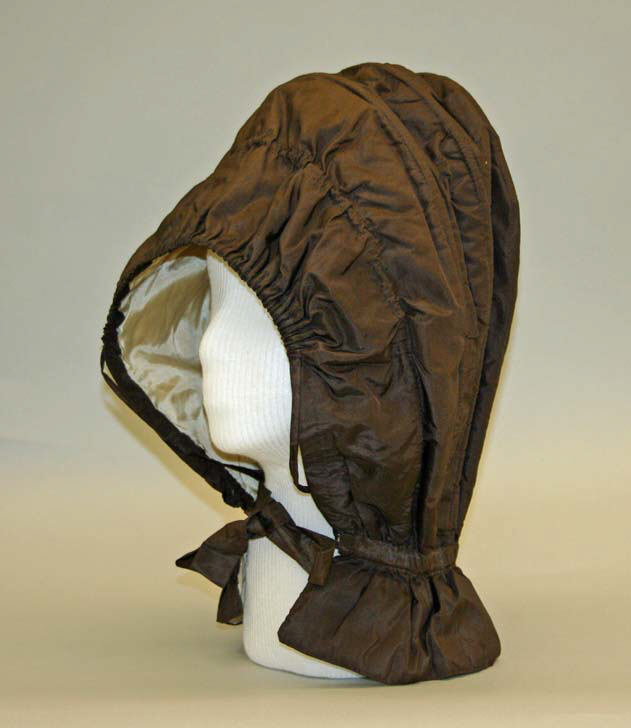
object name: calash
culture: american or european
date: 1780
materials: silk